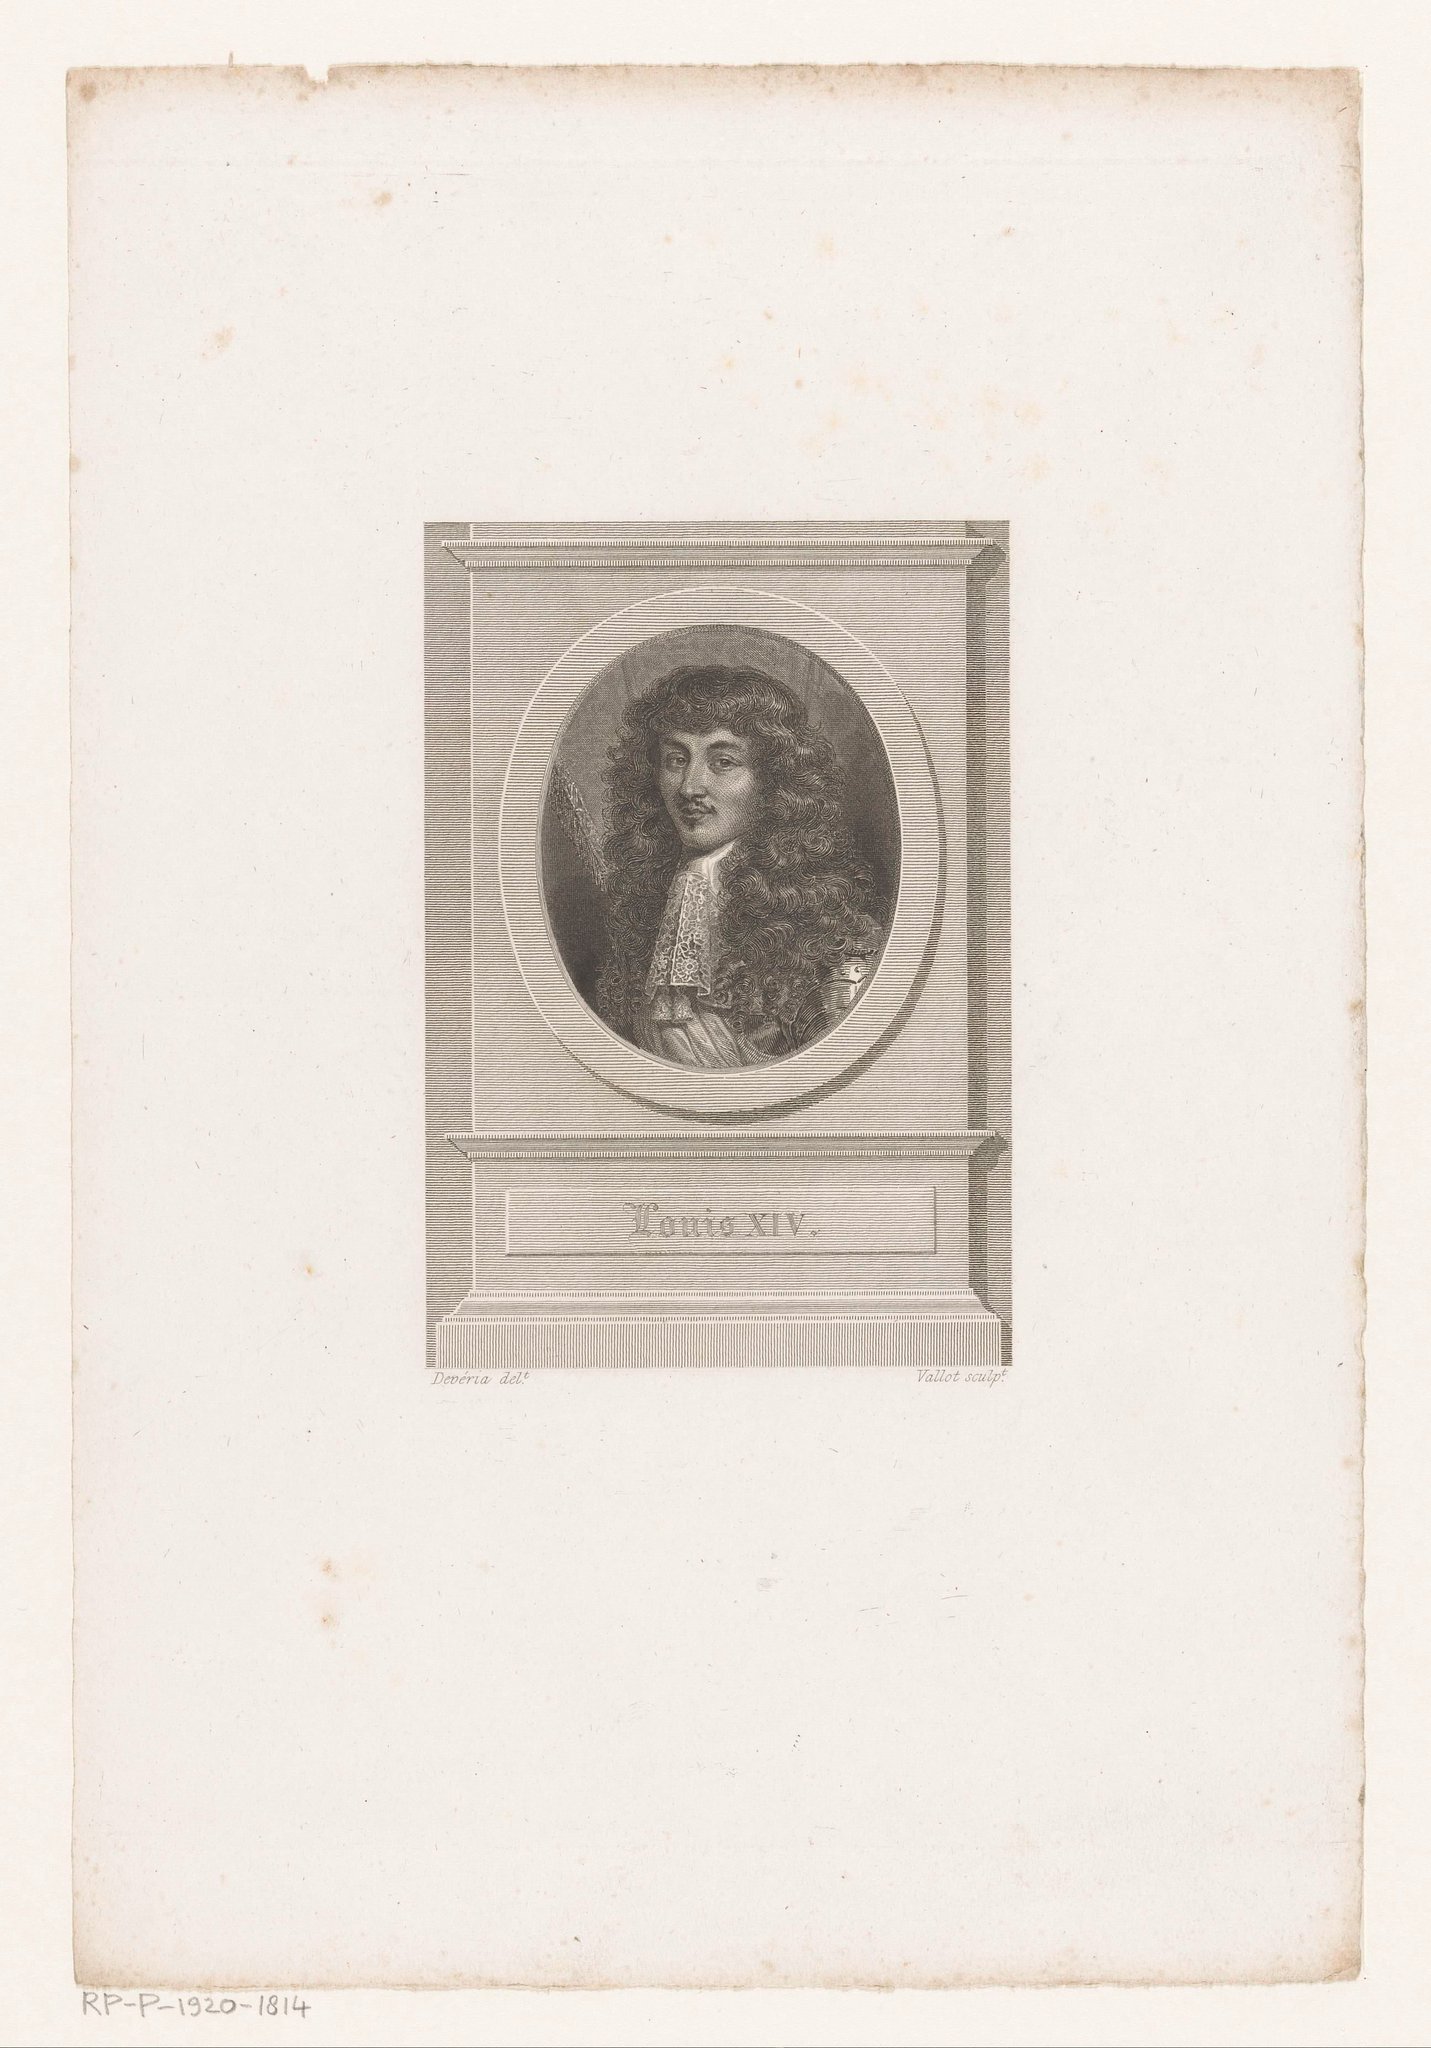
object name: print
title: Louis XIV.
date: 1823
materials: paper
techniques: engraving, etching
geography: paris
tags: lodewijk xiv (koning van frankrijk), historical persons, king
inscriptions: collector's mark: Lugt 2228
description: Betreft waarschijnlijk een boekillustratie.